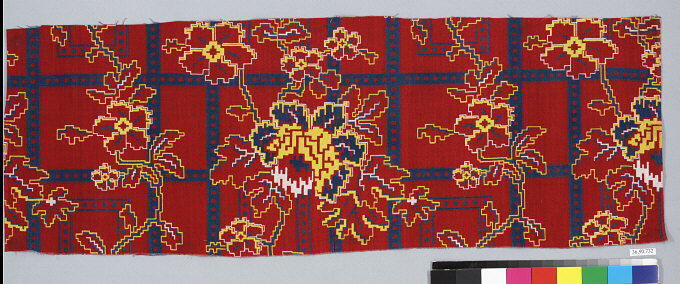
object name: piece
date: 1867-1900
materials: cotton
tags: flowers,leaves